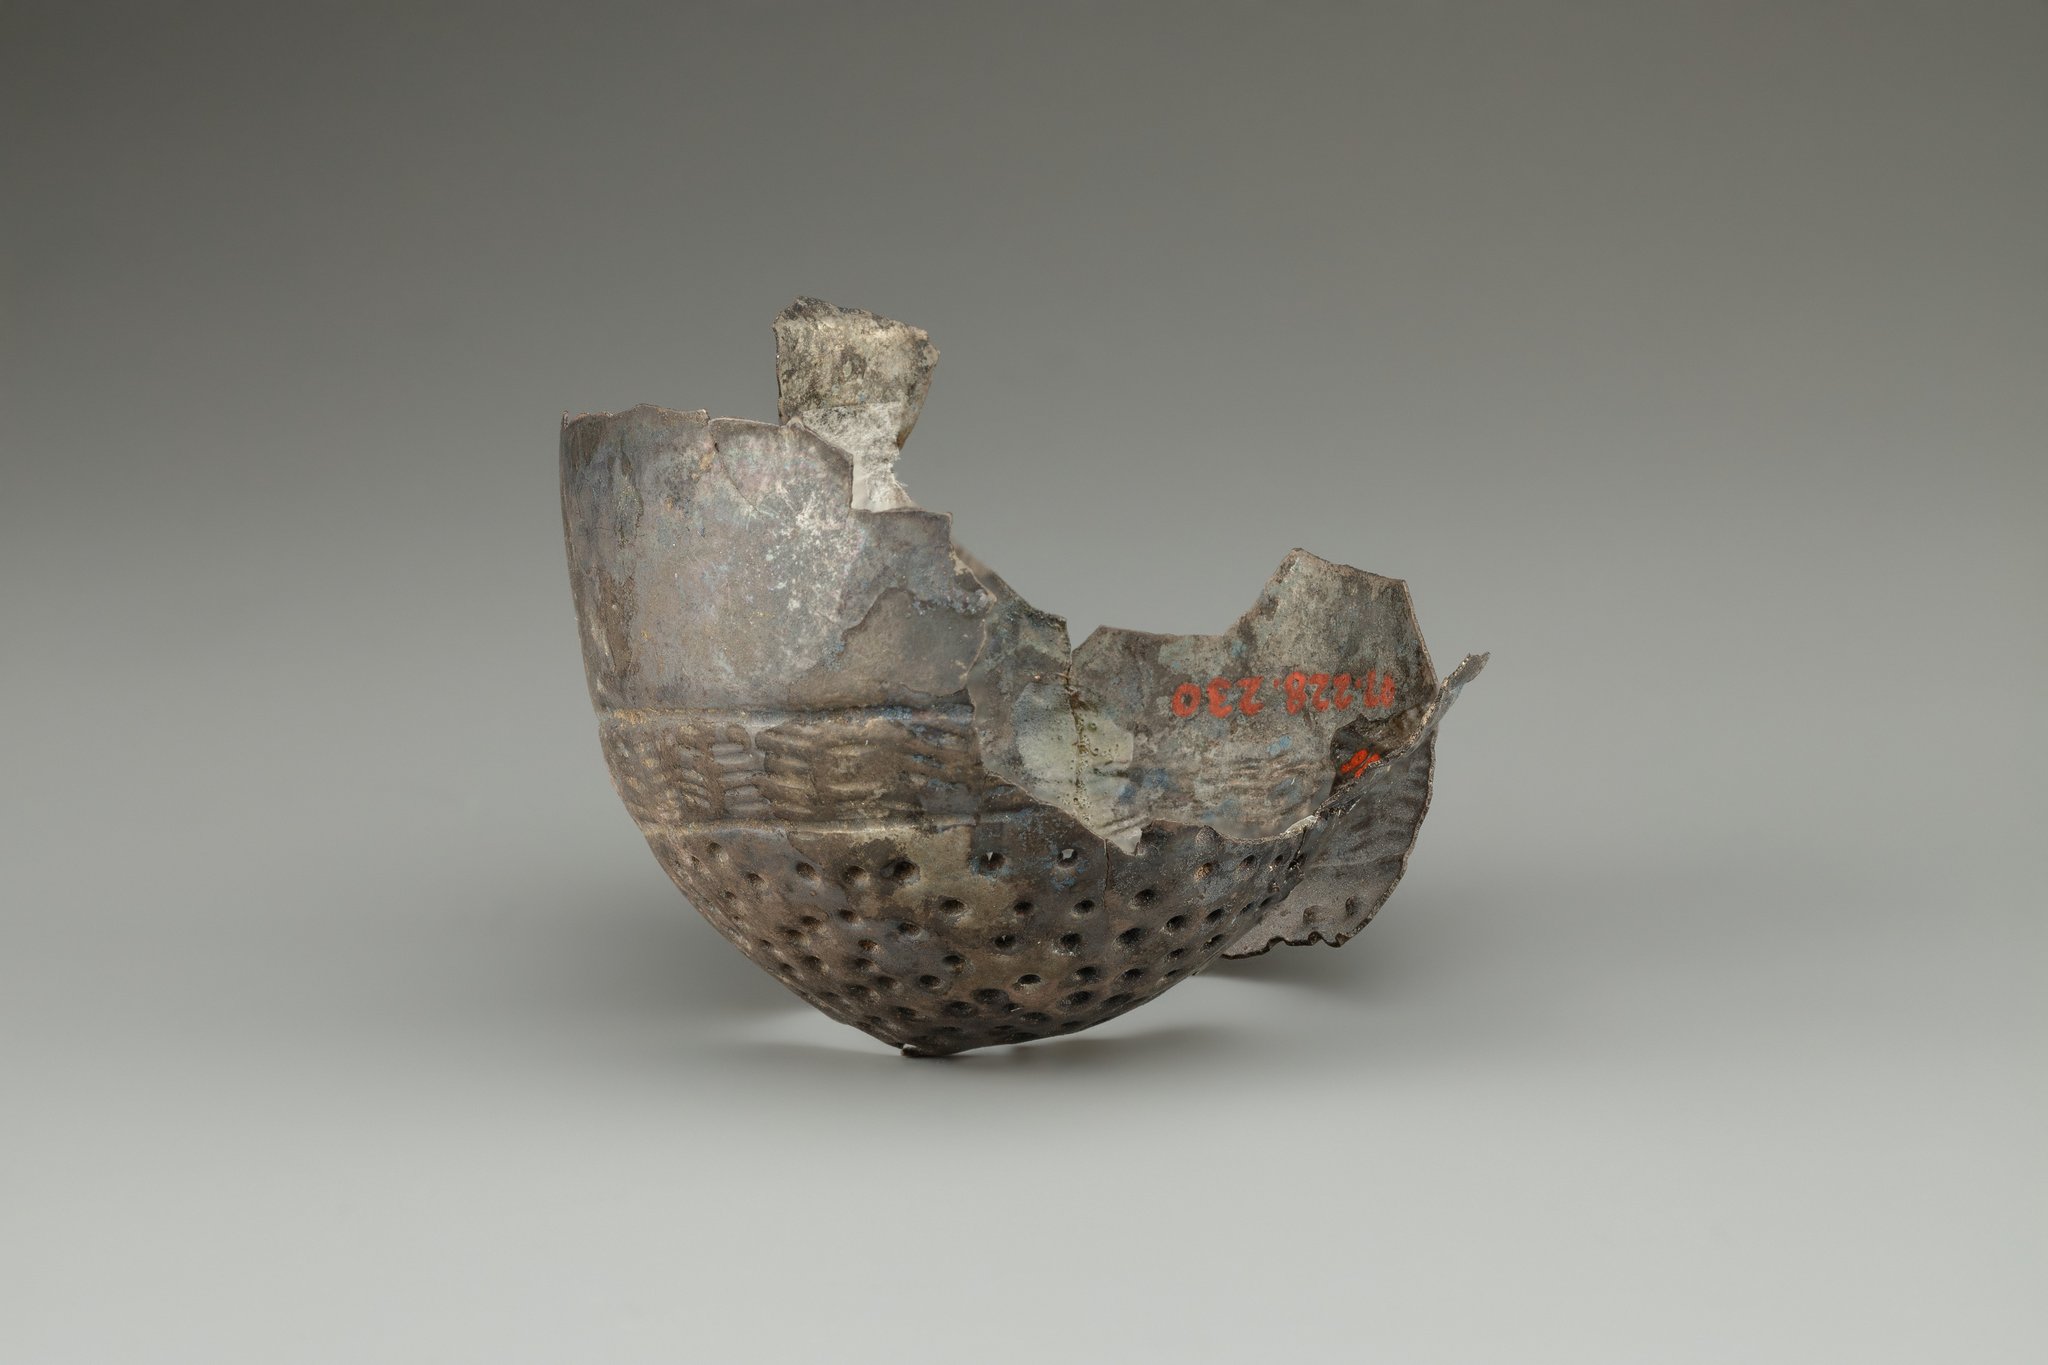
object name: strainer or vase fragment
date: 1295-1070 BCE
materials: silver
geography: egypt